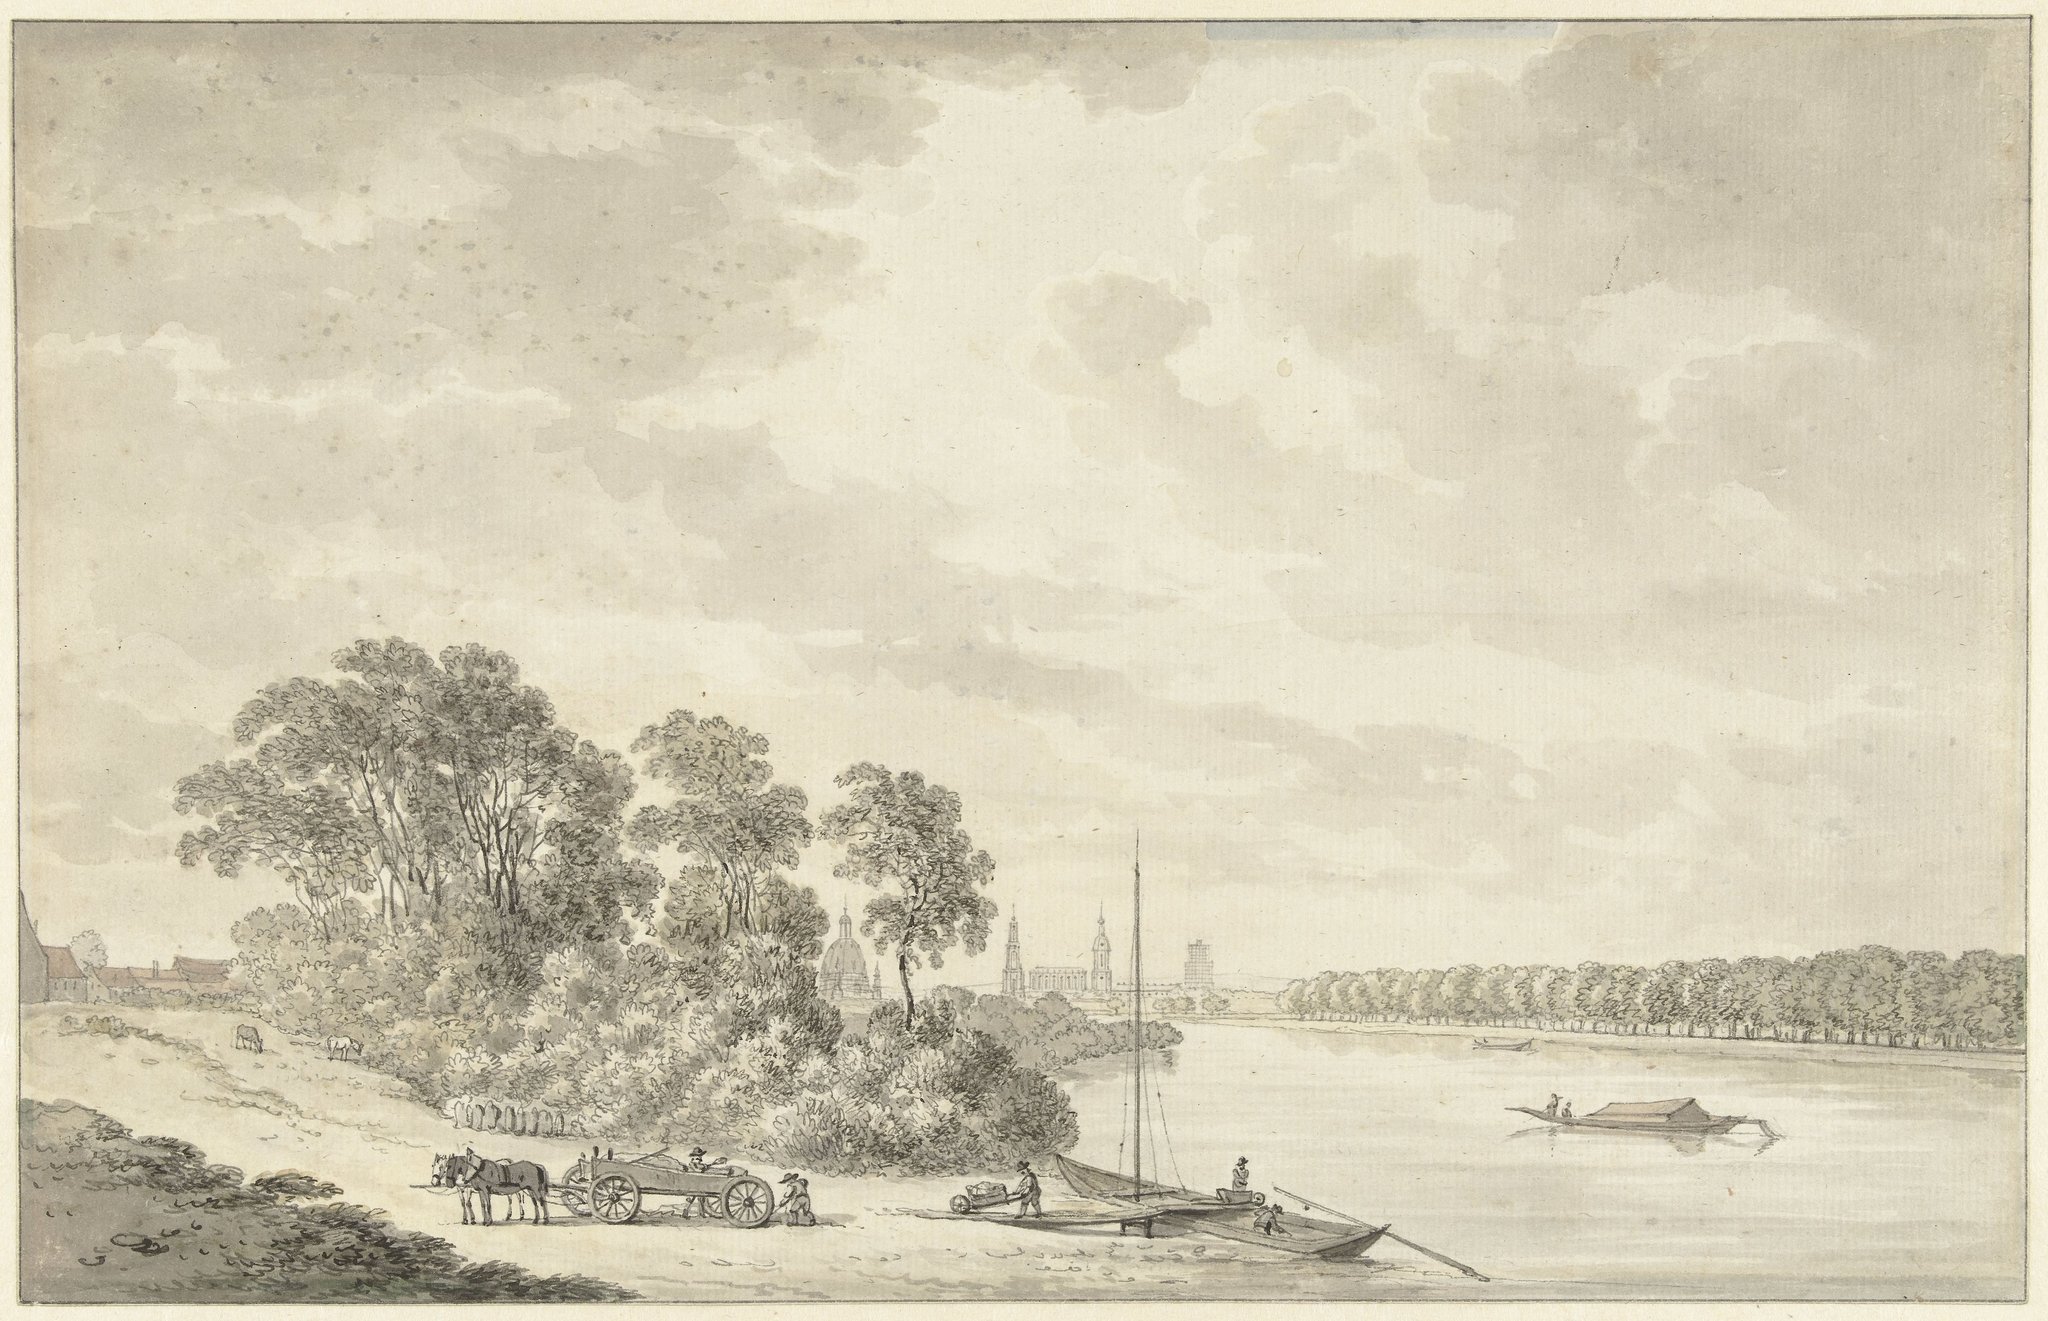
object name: drawing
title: Gezicht op Dresden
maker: daniël dupré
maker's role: draughtsman, print maker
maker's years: 1751-1817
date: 1786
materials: chalk, ink, paper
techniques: brush, pen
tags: prospect of city, town panorama, silhouette of city, germany